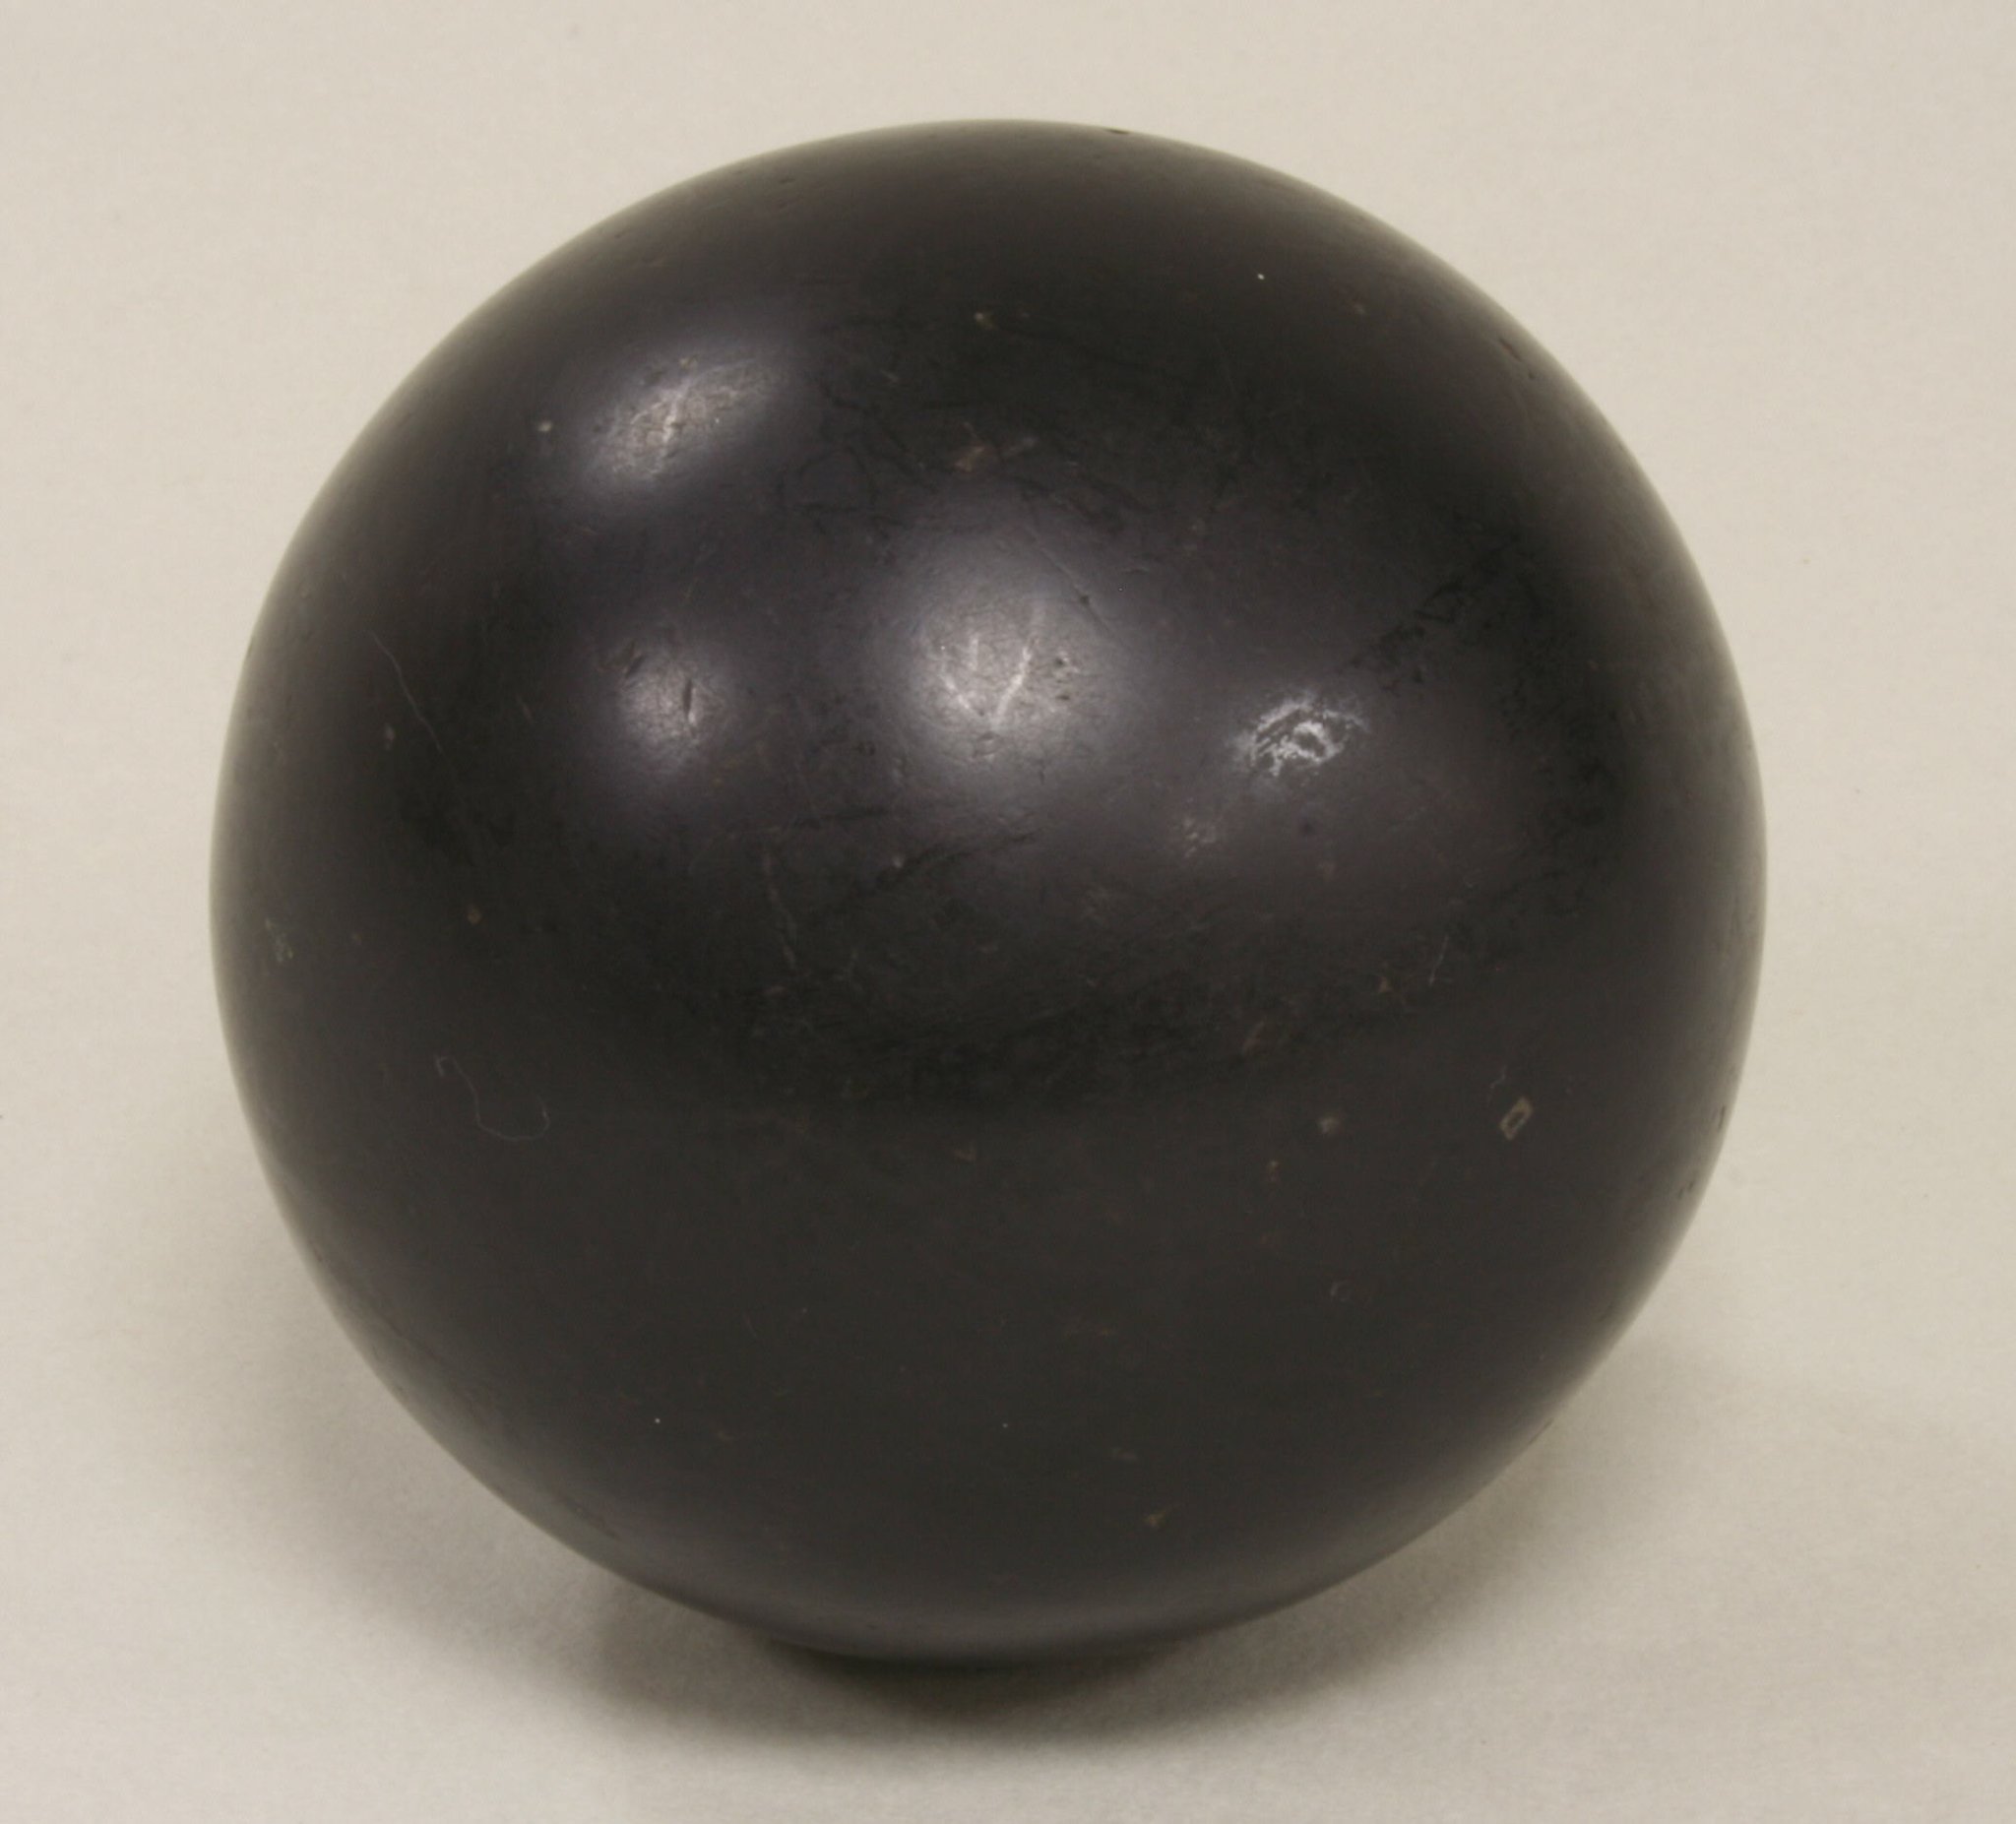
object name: sphere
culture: mexican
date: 1501-1600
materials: stone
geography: mexico